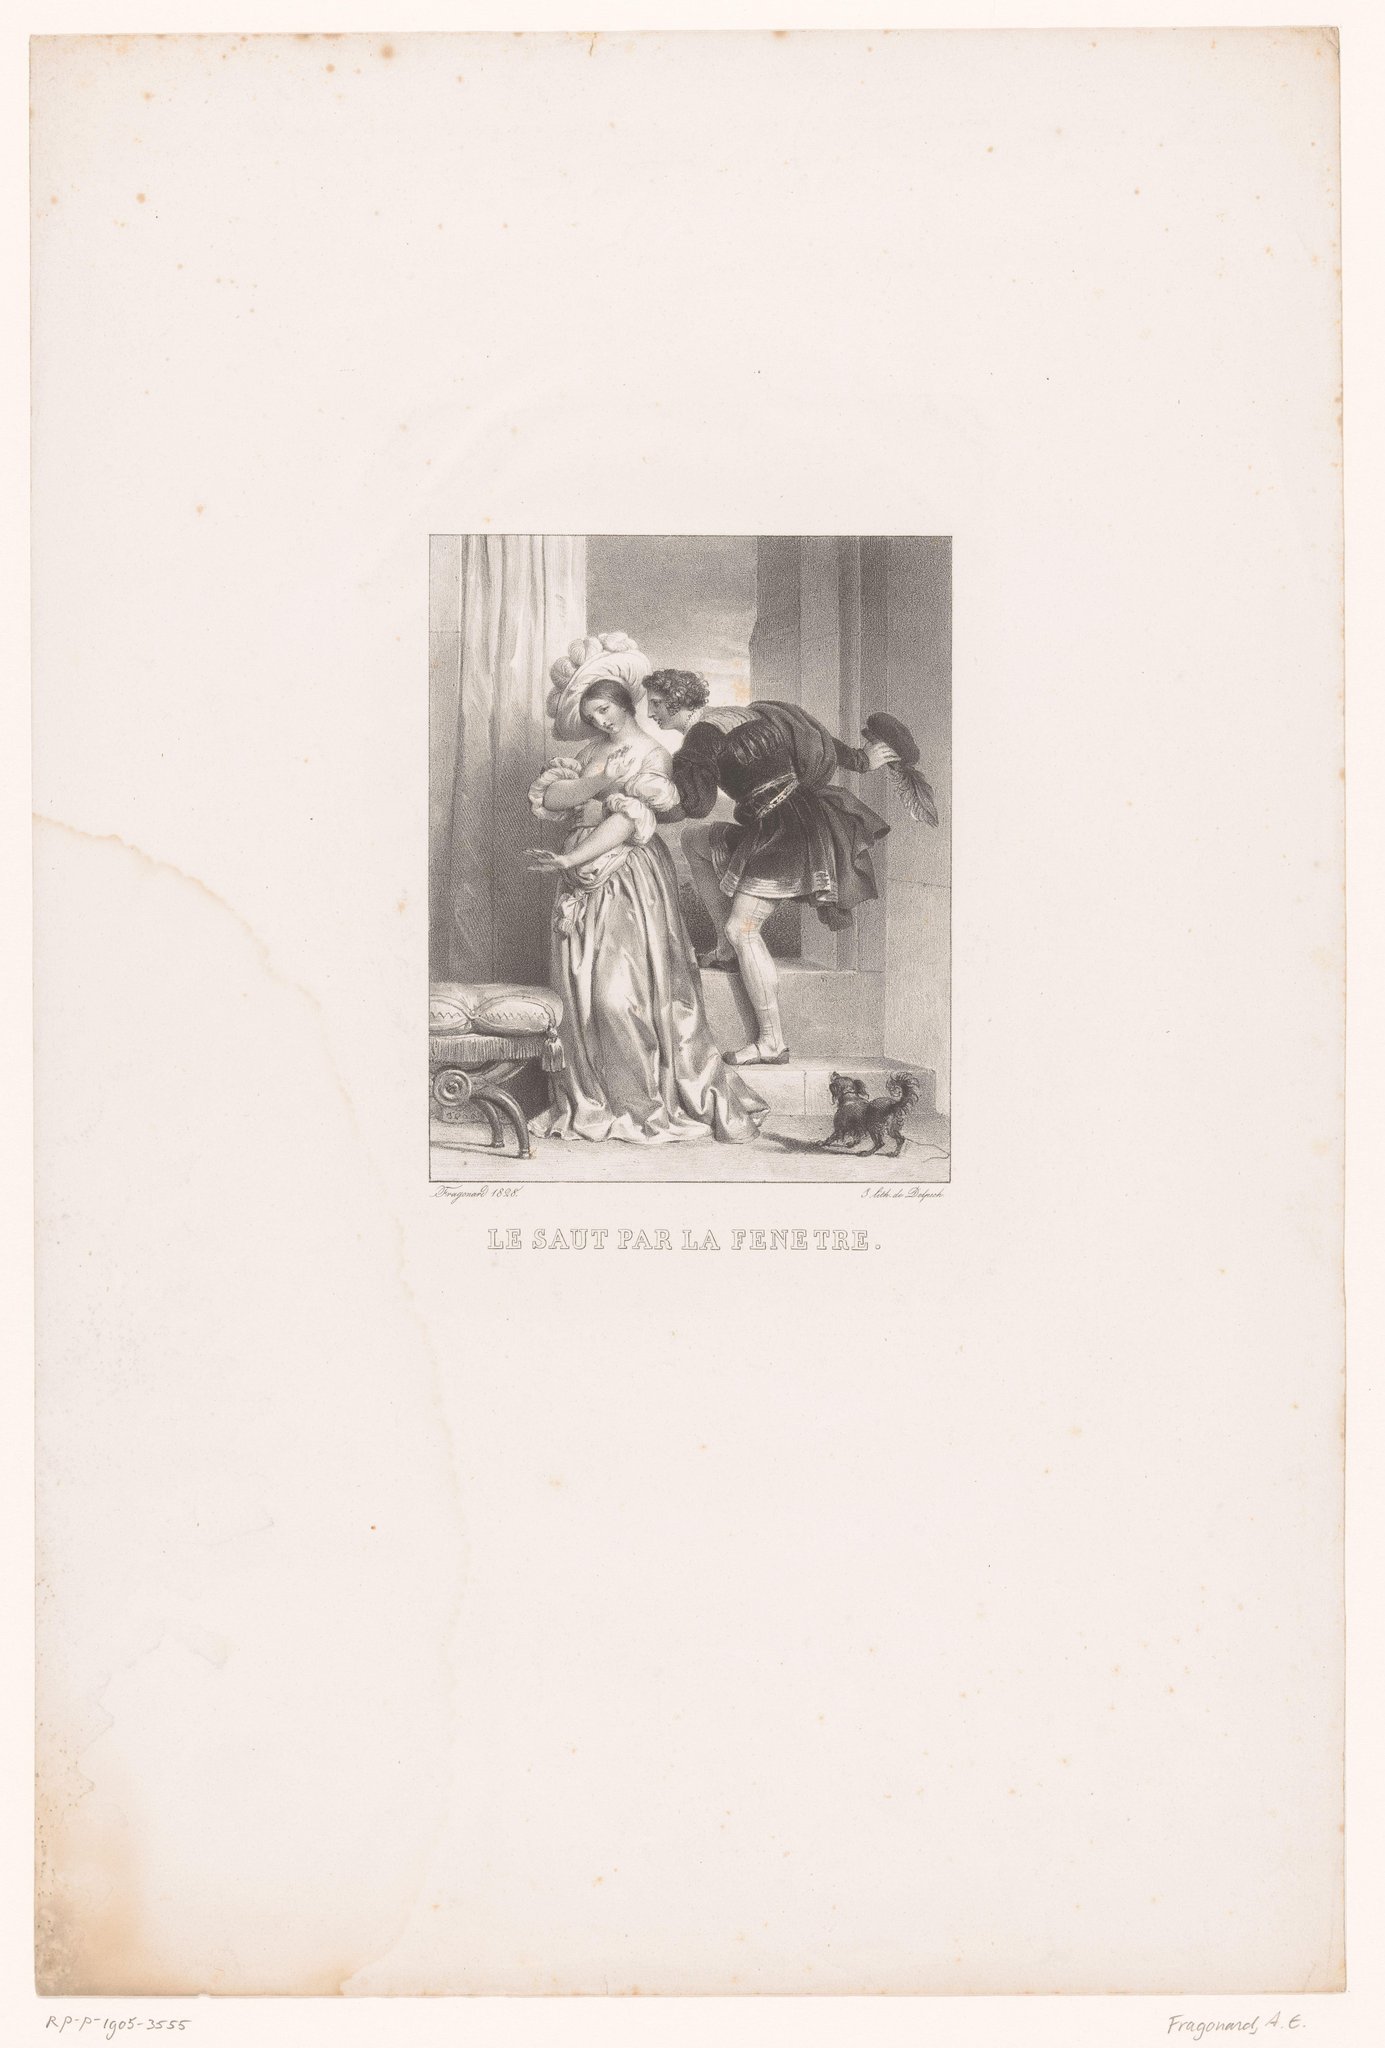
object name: print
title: Le saut par la fenêtre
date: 1828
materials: paper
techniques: lithograph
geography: paris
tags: lovers' tussle, seeking death, suicide, human figure at (open) window, seen from inside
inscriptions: collector's mark: Lugt 2228a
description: De jongeman probeert de jonge vrouw over te halen om samen met hem door het raam te springen.